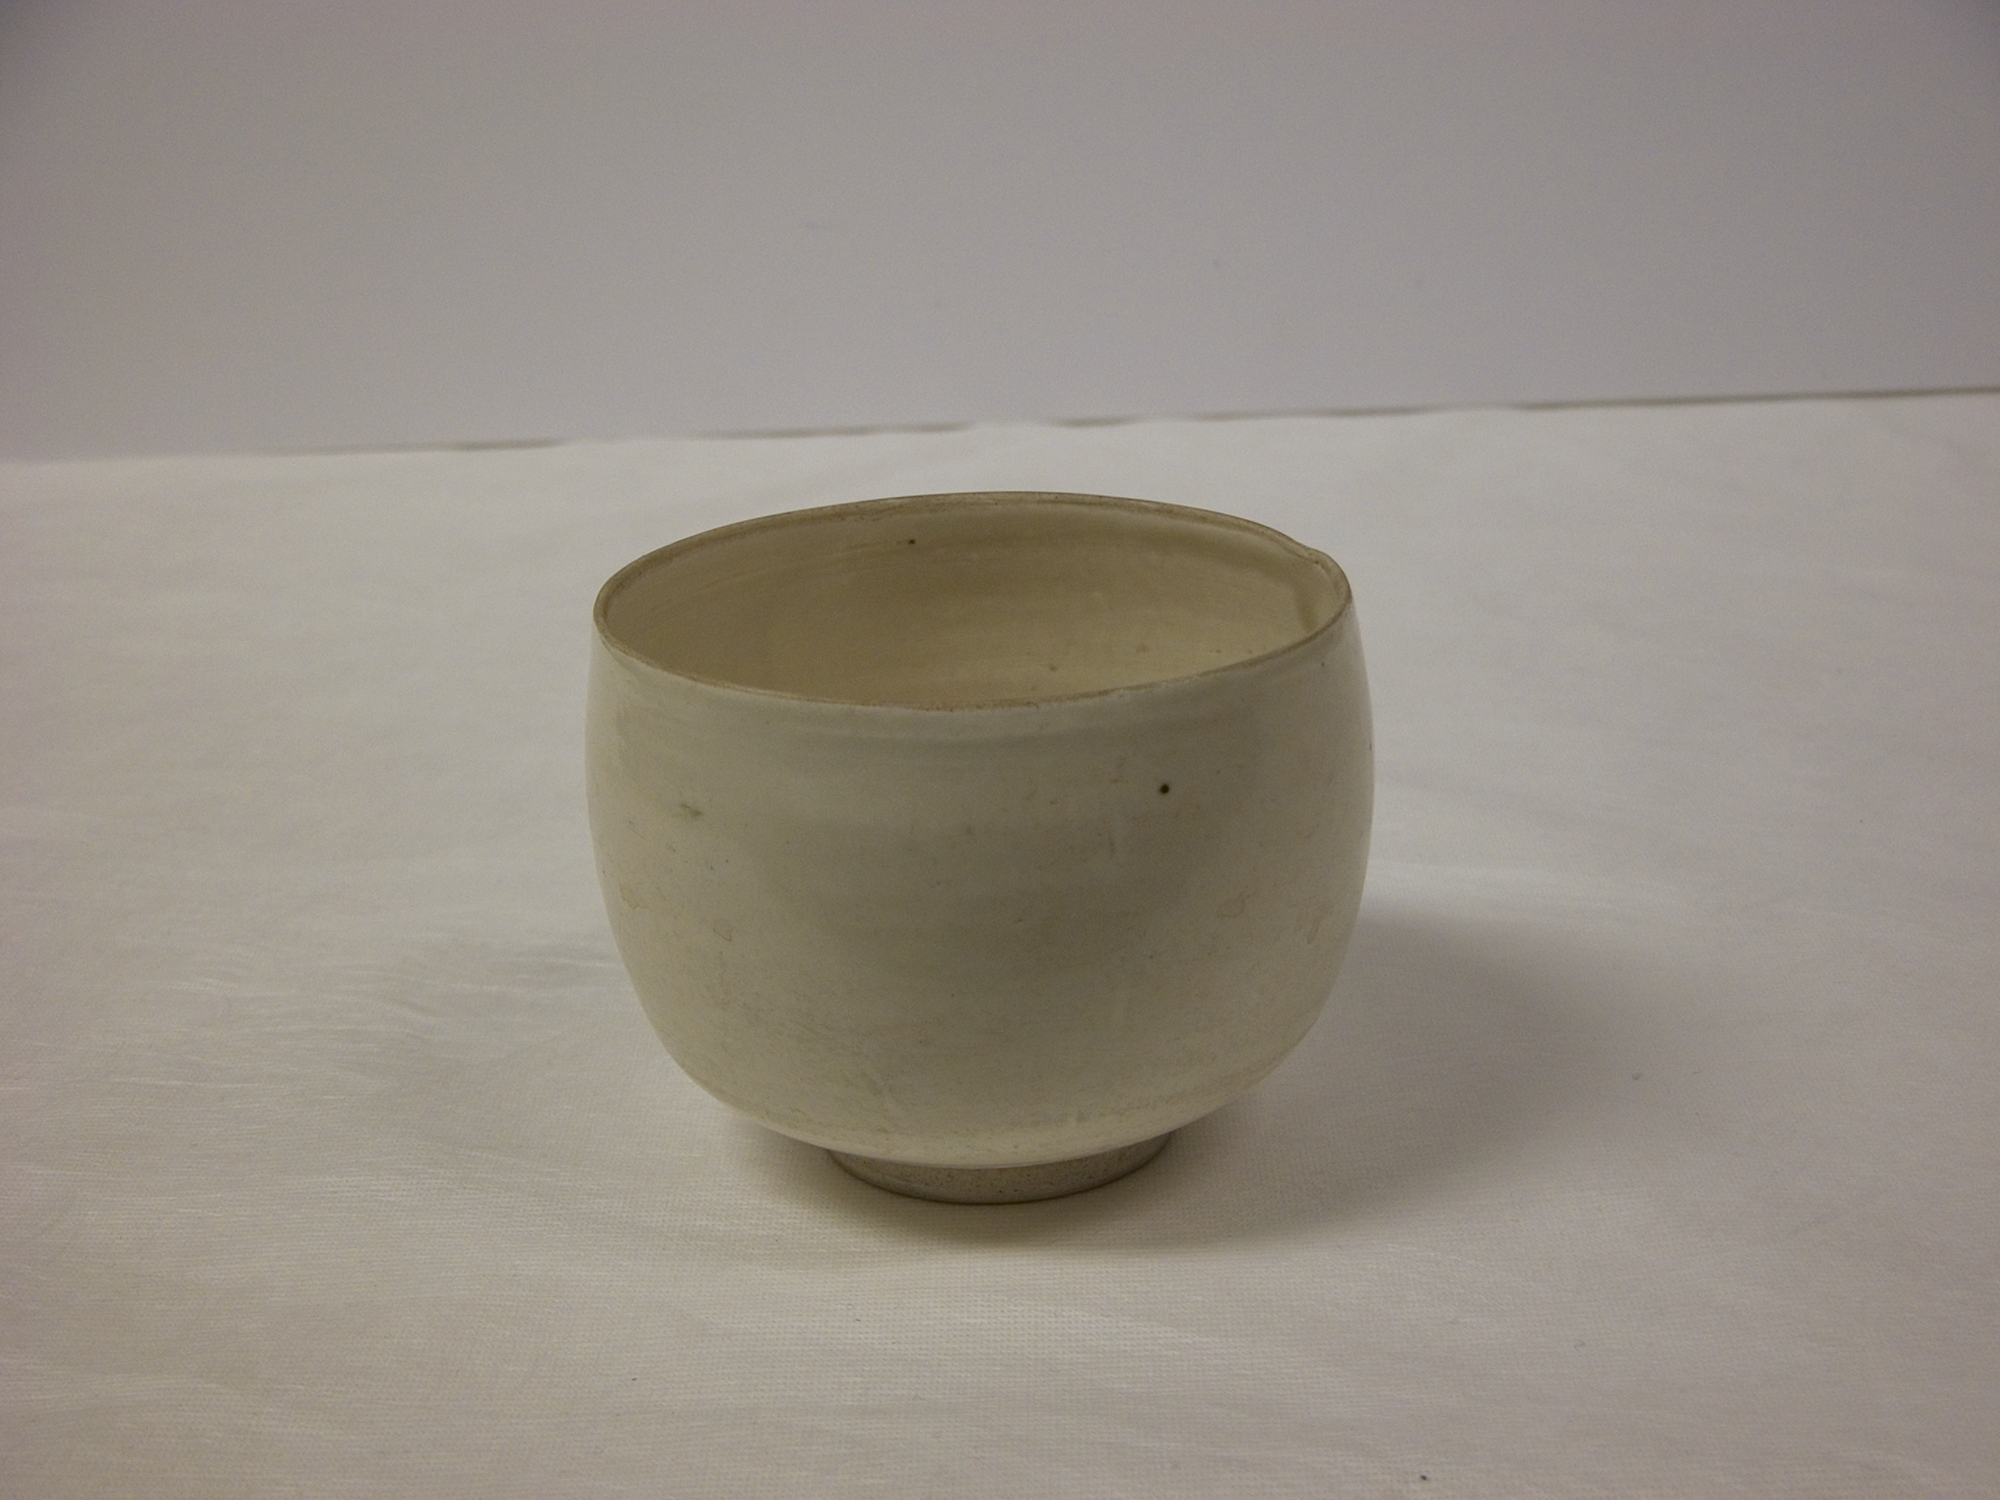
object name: bowl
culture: chinese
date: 960-1279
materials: pottery